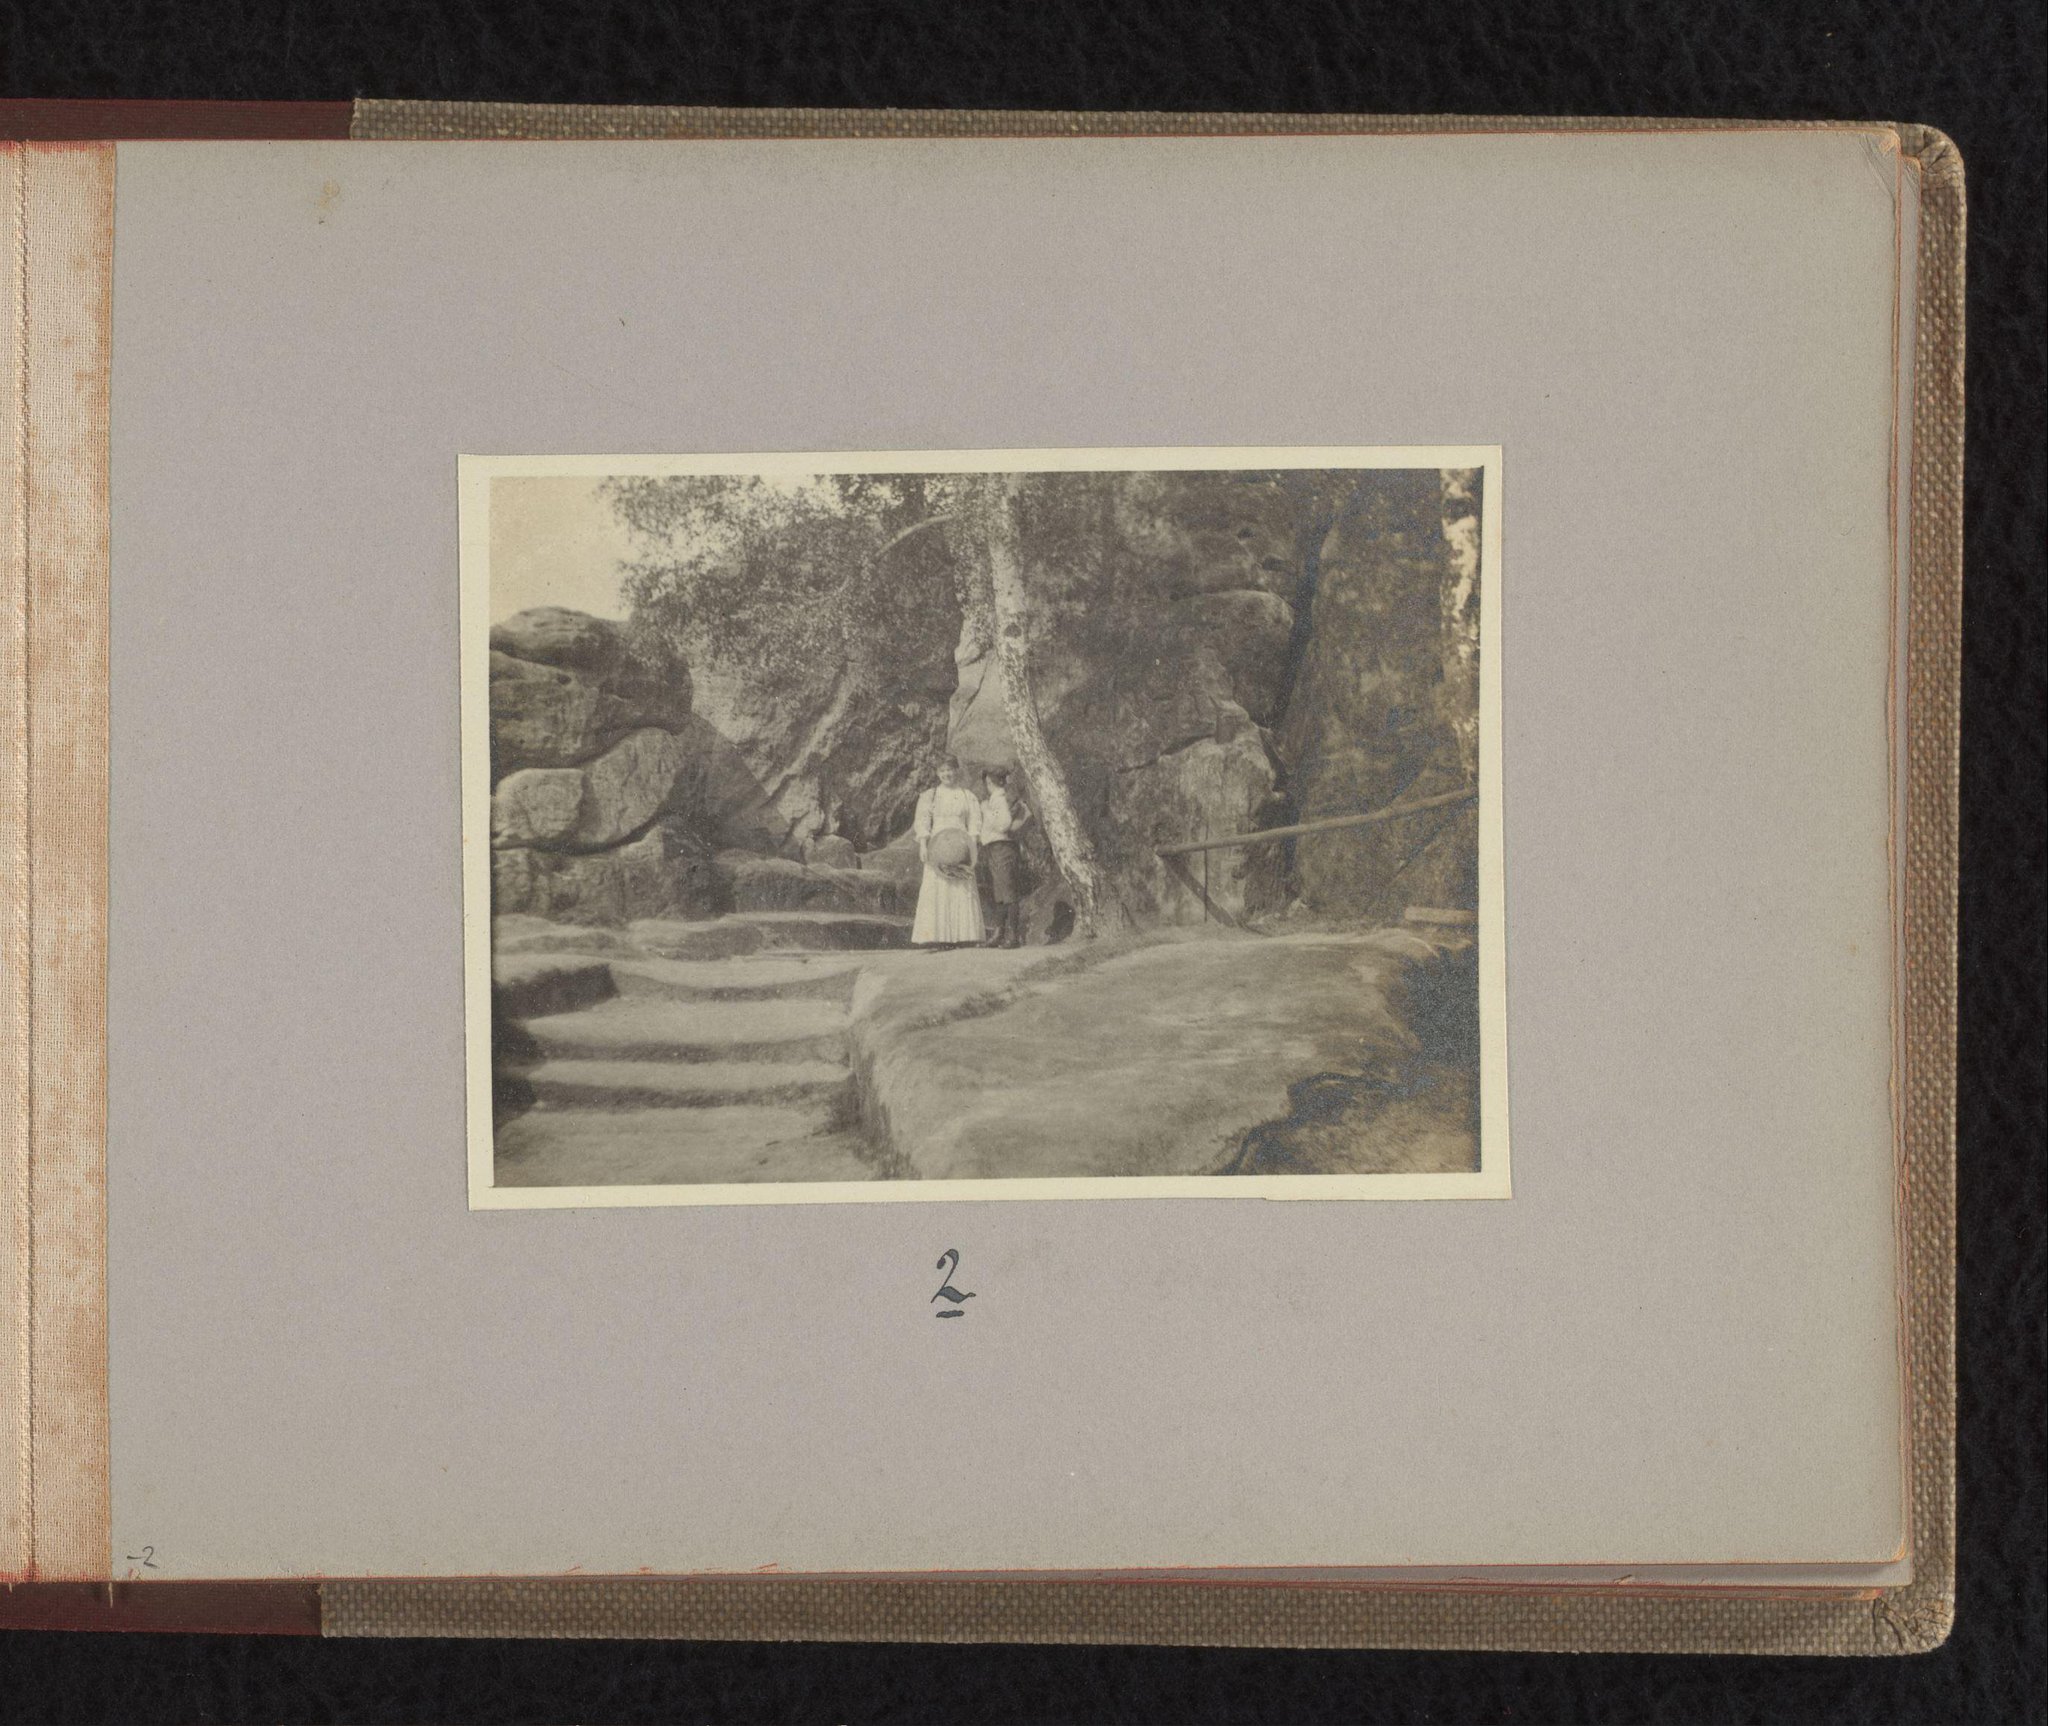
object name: album leaf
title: Bastei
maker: johan herman kessler (jan)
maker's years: 1892-1978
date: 1910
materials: paper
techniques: gelatin silver print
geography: saxony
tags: the hague, hermann johannes kessler (boelie), rock-formations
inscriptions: number: ‘2’